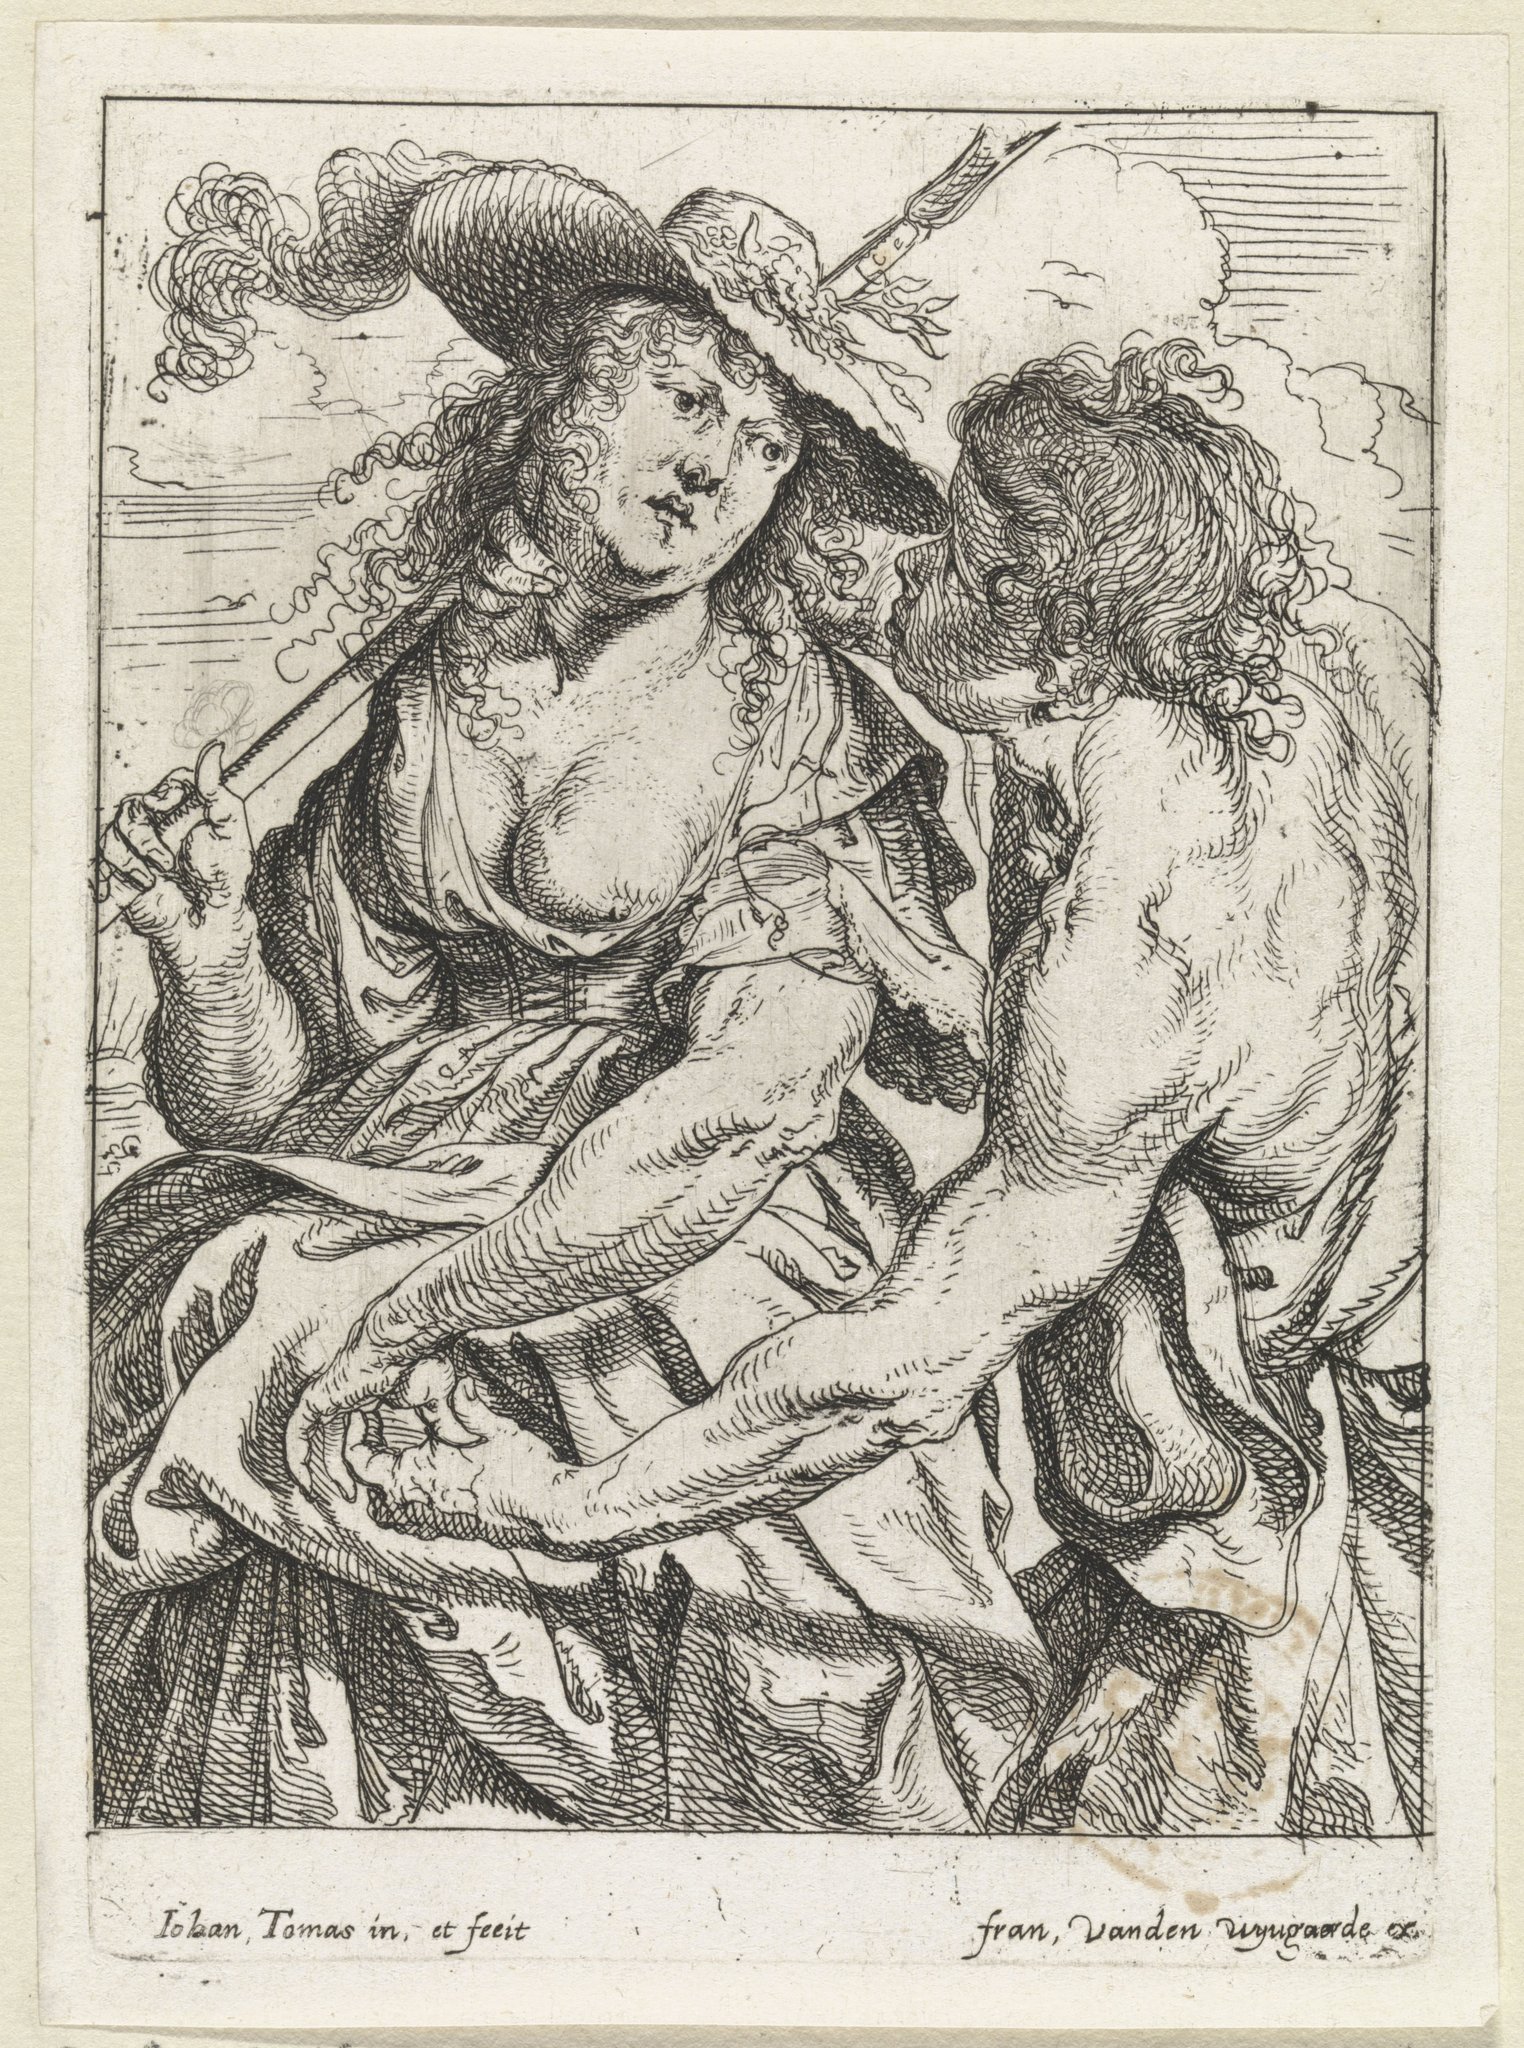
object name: print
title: Herderin en jonge man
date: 1627-1678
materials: paper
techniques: engraving, etching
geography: antwerp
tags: herding, herdsman, herdswoman, shepherd, shepherdess, cowherd, etc., couple of lovers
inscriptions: collector's mark: Lugt 240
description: Een herderin met ontblote borst kijkt om over haar schouder naar een man, die haar hand pakt.